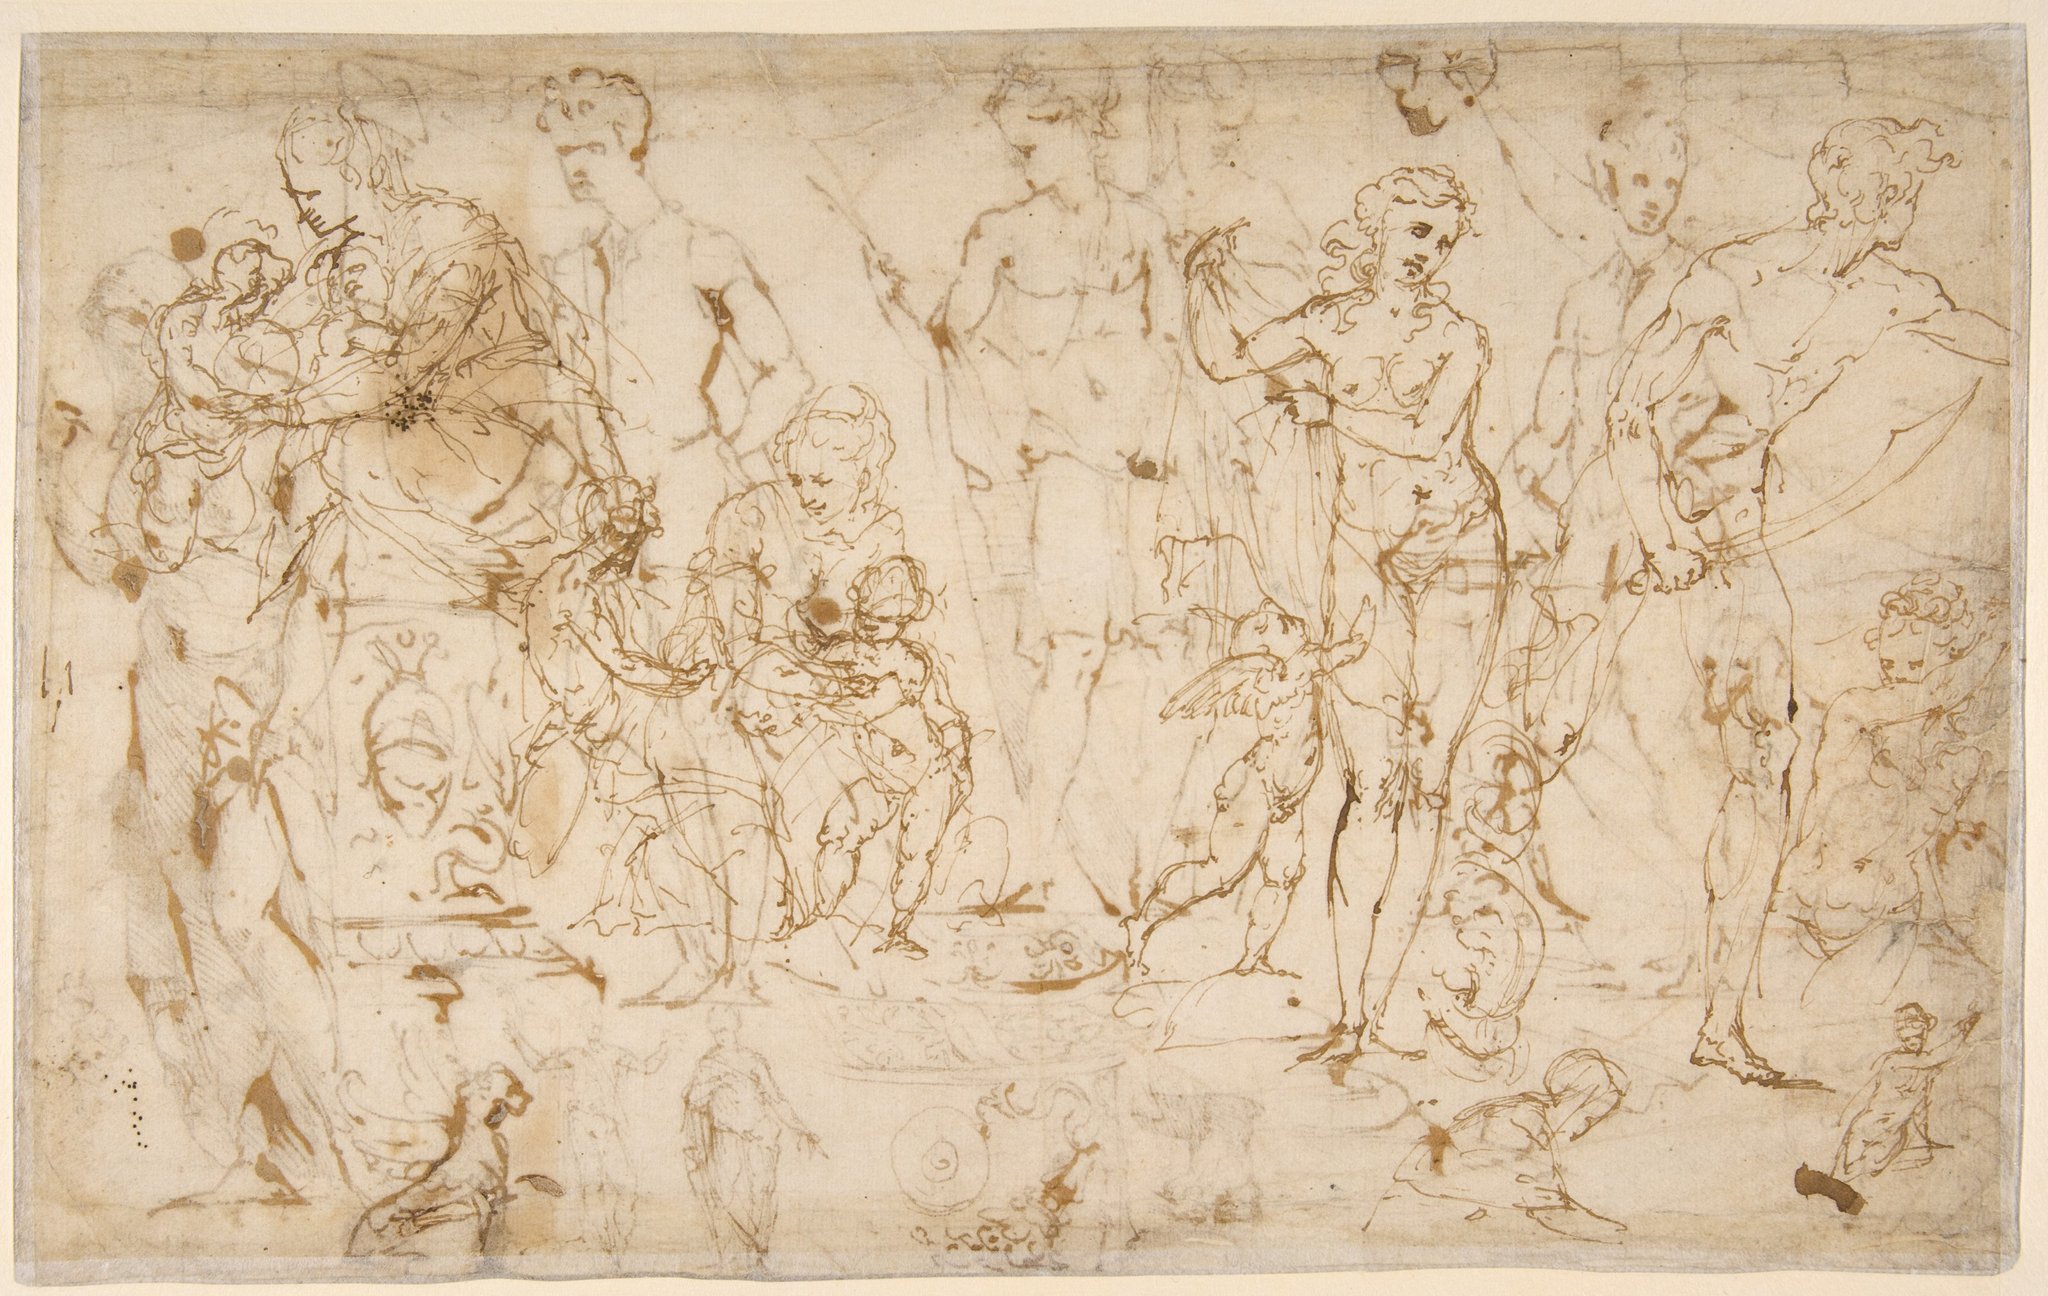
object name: drawing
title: Sheet of Figure Studies and Ornamental Motifs (recto and verso)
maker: vincenzo tamagni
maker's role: artist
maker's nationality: italian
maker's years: 1492-1530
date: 1520-1530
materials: ink, drawing material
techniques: pen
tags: male nudes,female nudes